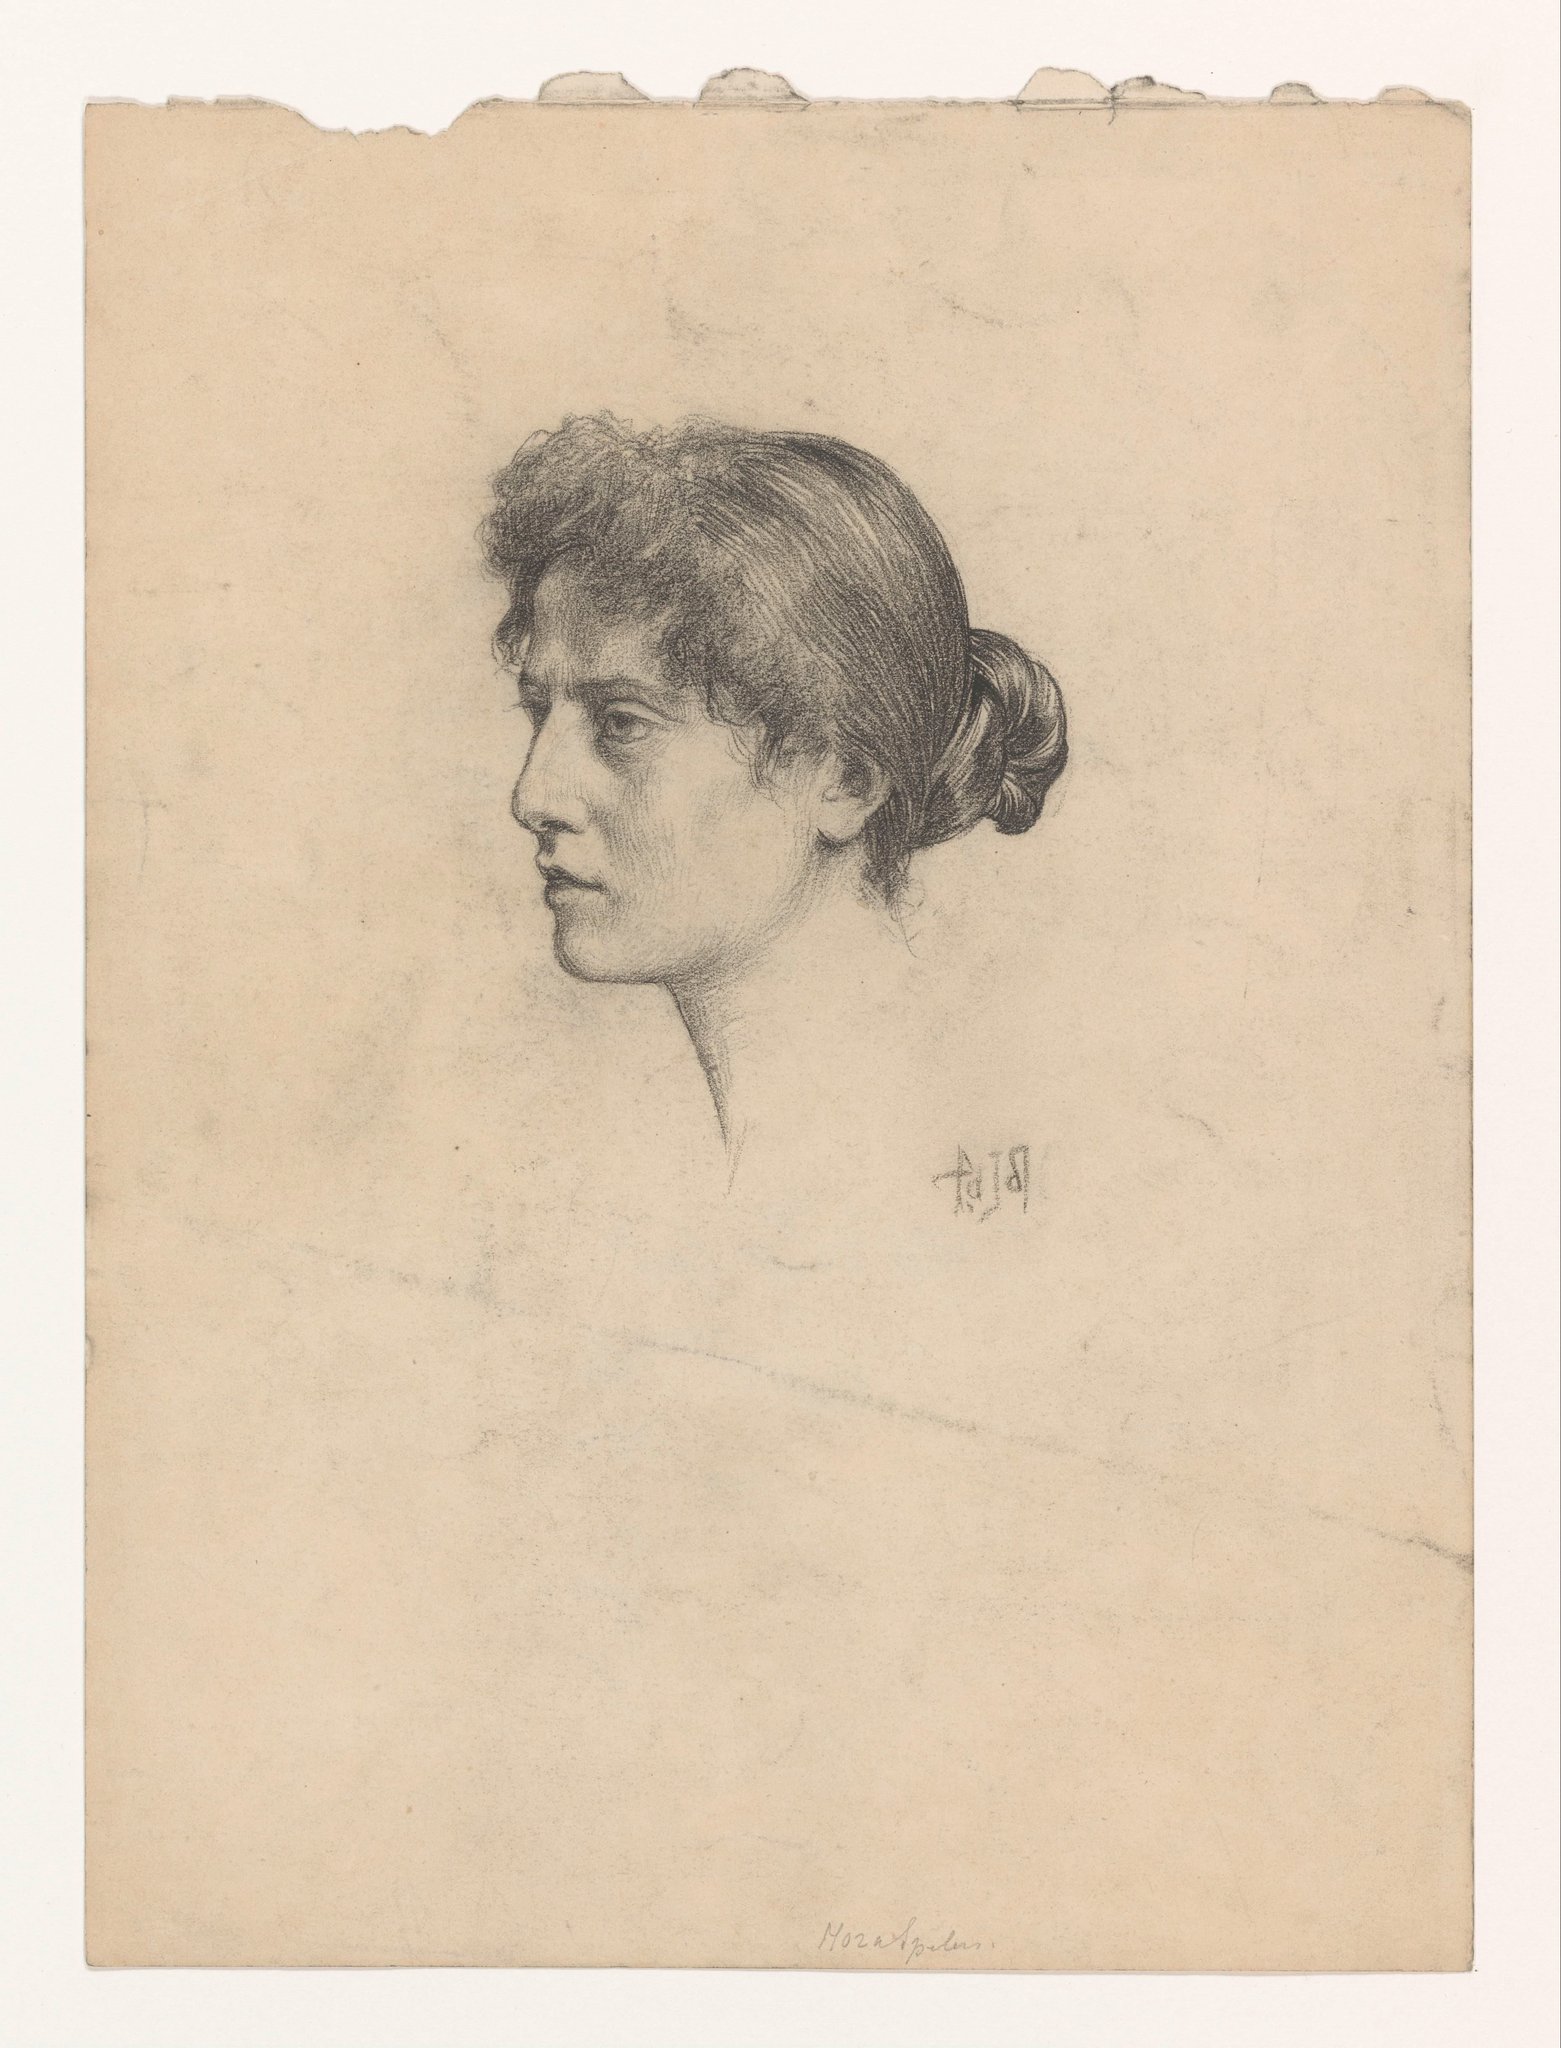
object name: drawing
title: Vrouwenkop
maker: pieter de josselin de jong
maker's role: draughtsman, painter, print maker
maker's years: 1861-1906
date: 1871-1906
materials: chalk, paper